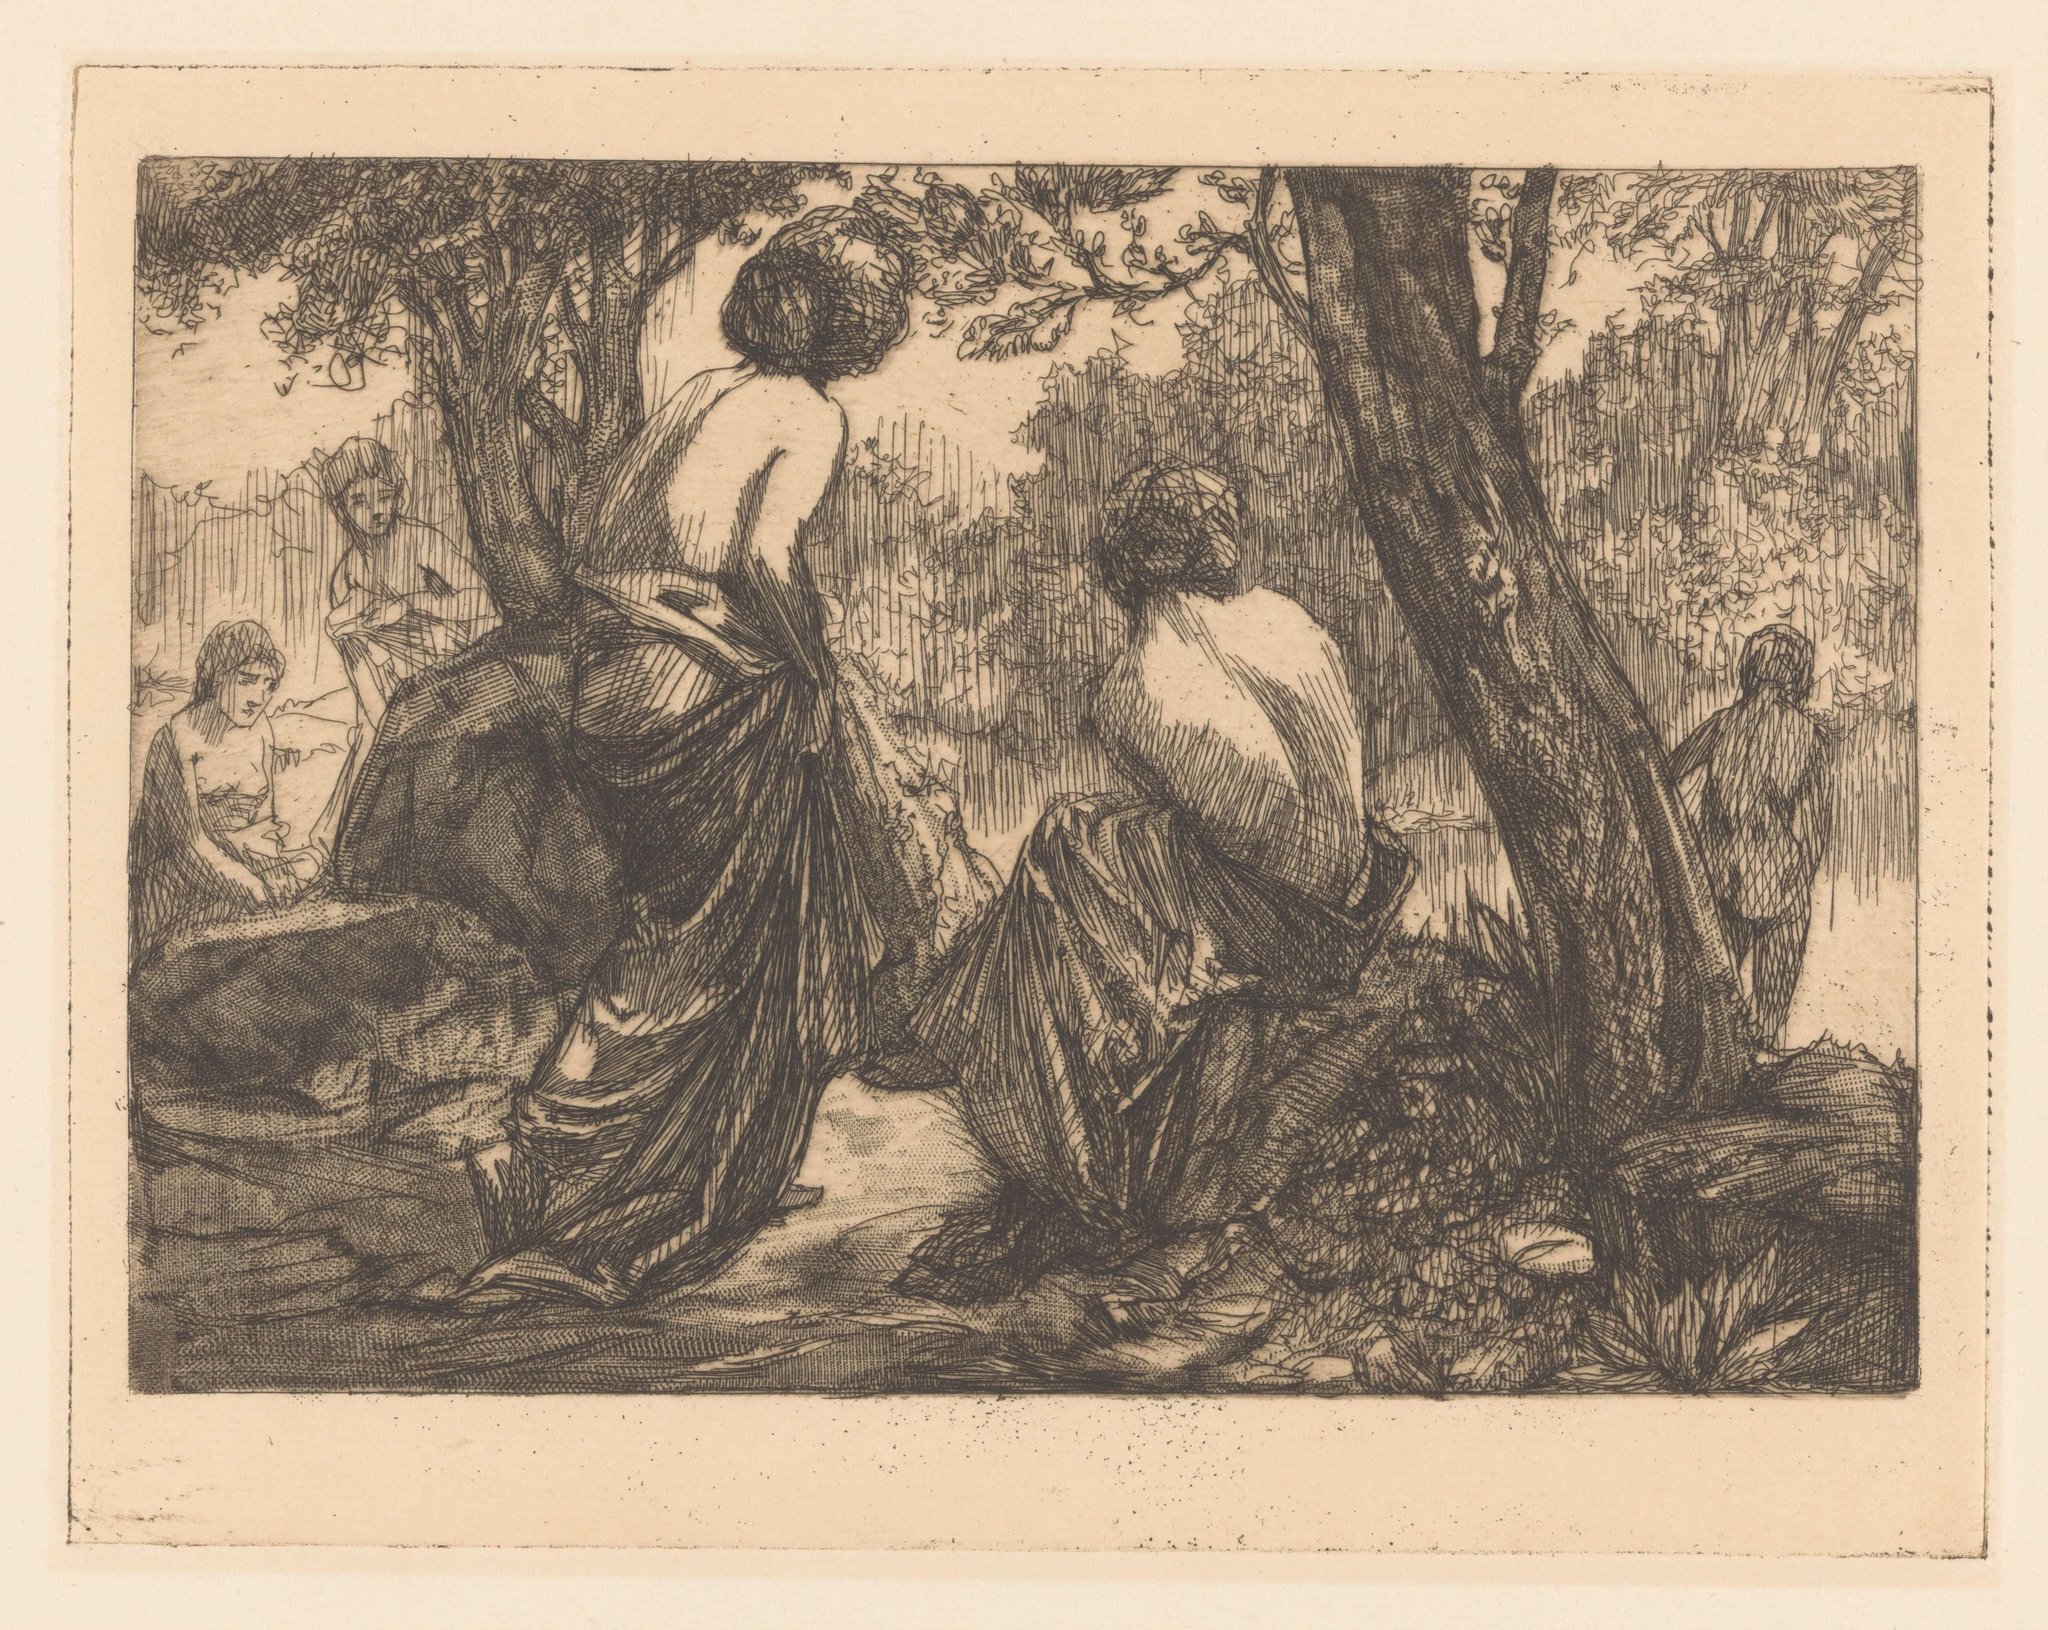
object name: print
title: Badende vrouwen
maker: johannes josephus aarts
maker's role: draughtsman, print maker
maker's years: 1871-1934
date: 1881-1934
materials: paper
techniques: etching, roulette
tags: woman (showing herself) undressed, quasi-nude, taking a bath - aa - in the open air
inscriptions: collector's mark: Lugt 2760, watermark, collector's mark: Lugt 2228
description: Vijf gedeeltelijk en geheel ontklede vrouwen in een met bomen begroeid landschap. Achter hen bevindt zich water.